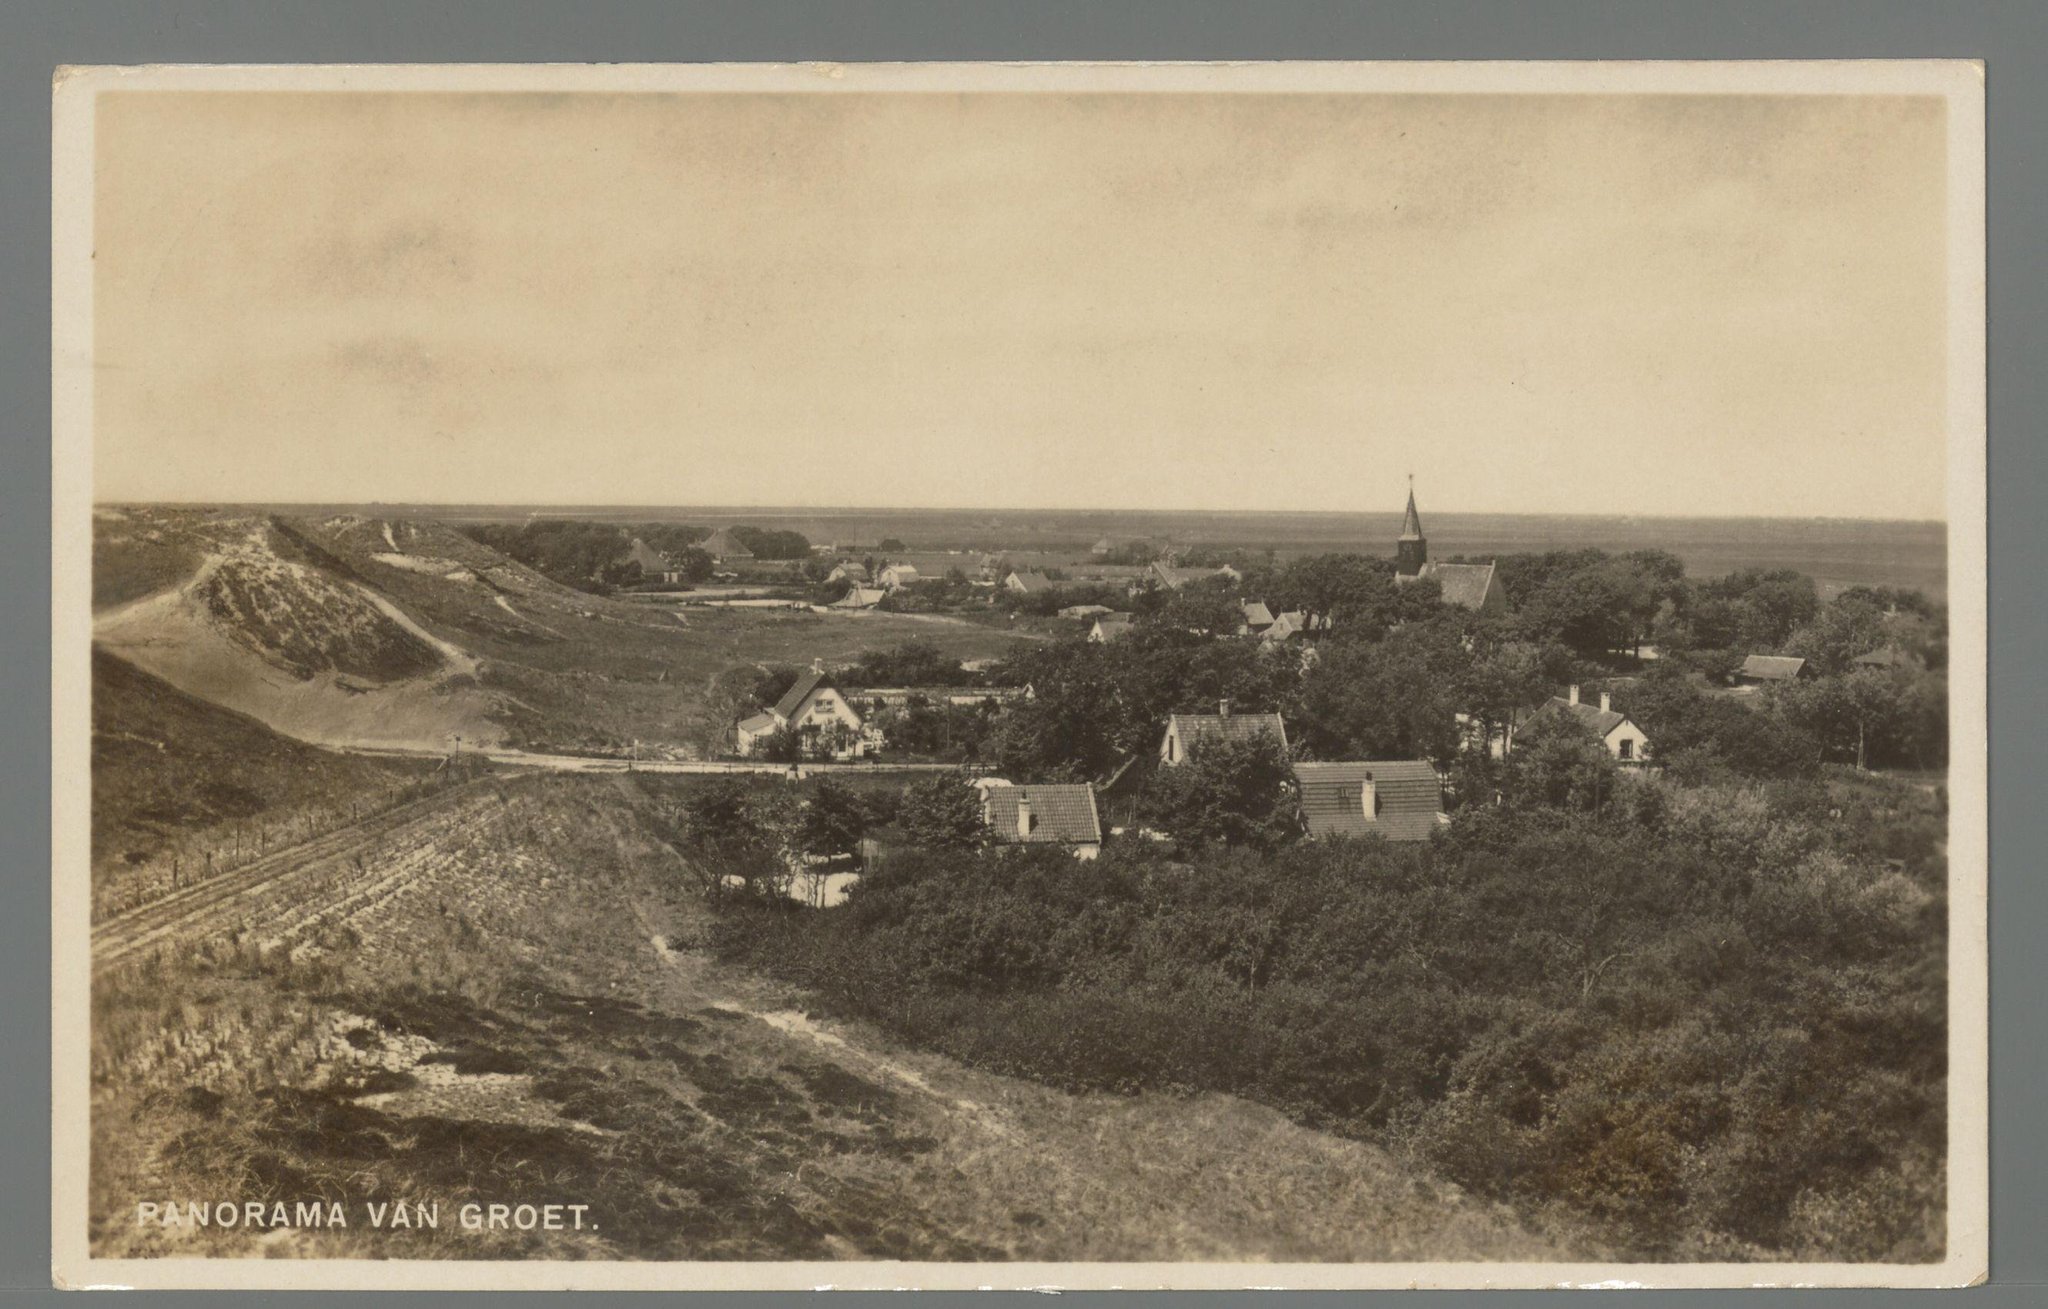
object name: photograph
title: PANORAMA VAN GROET.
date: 1929-1935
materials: photographic support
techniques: photography, writing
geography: schoorl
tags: city-view, and landscape with man-made constructions, dunes (sea not visible); in the dunes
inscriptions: postage stamp